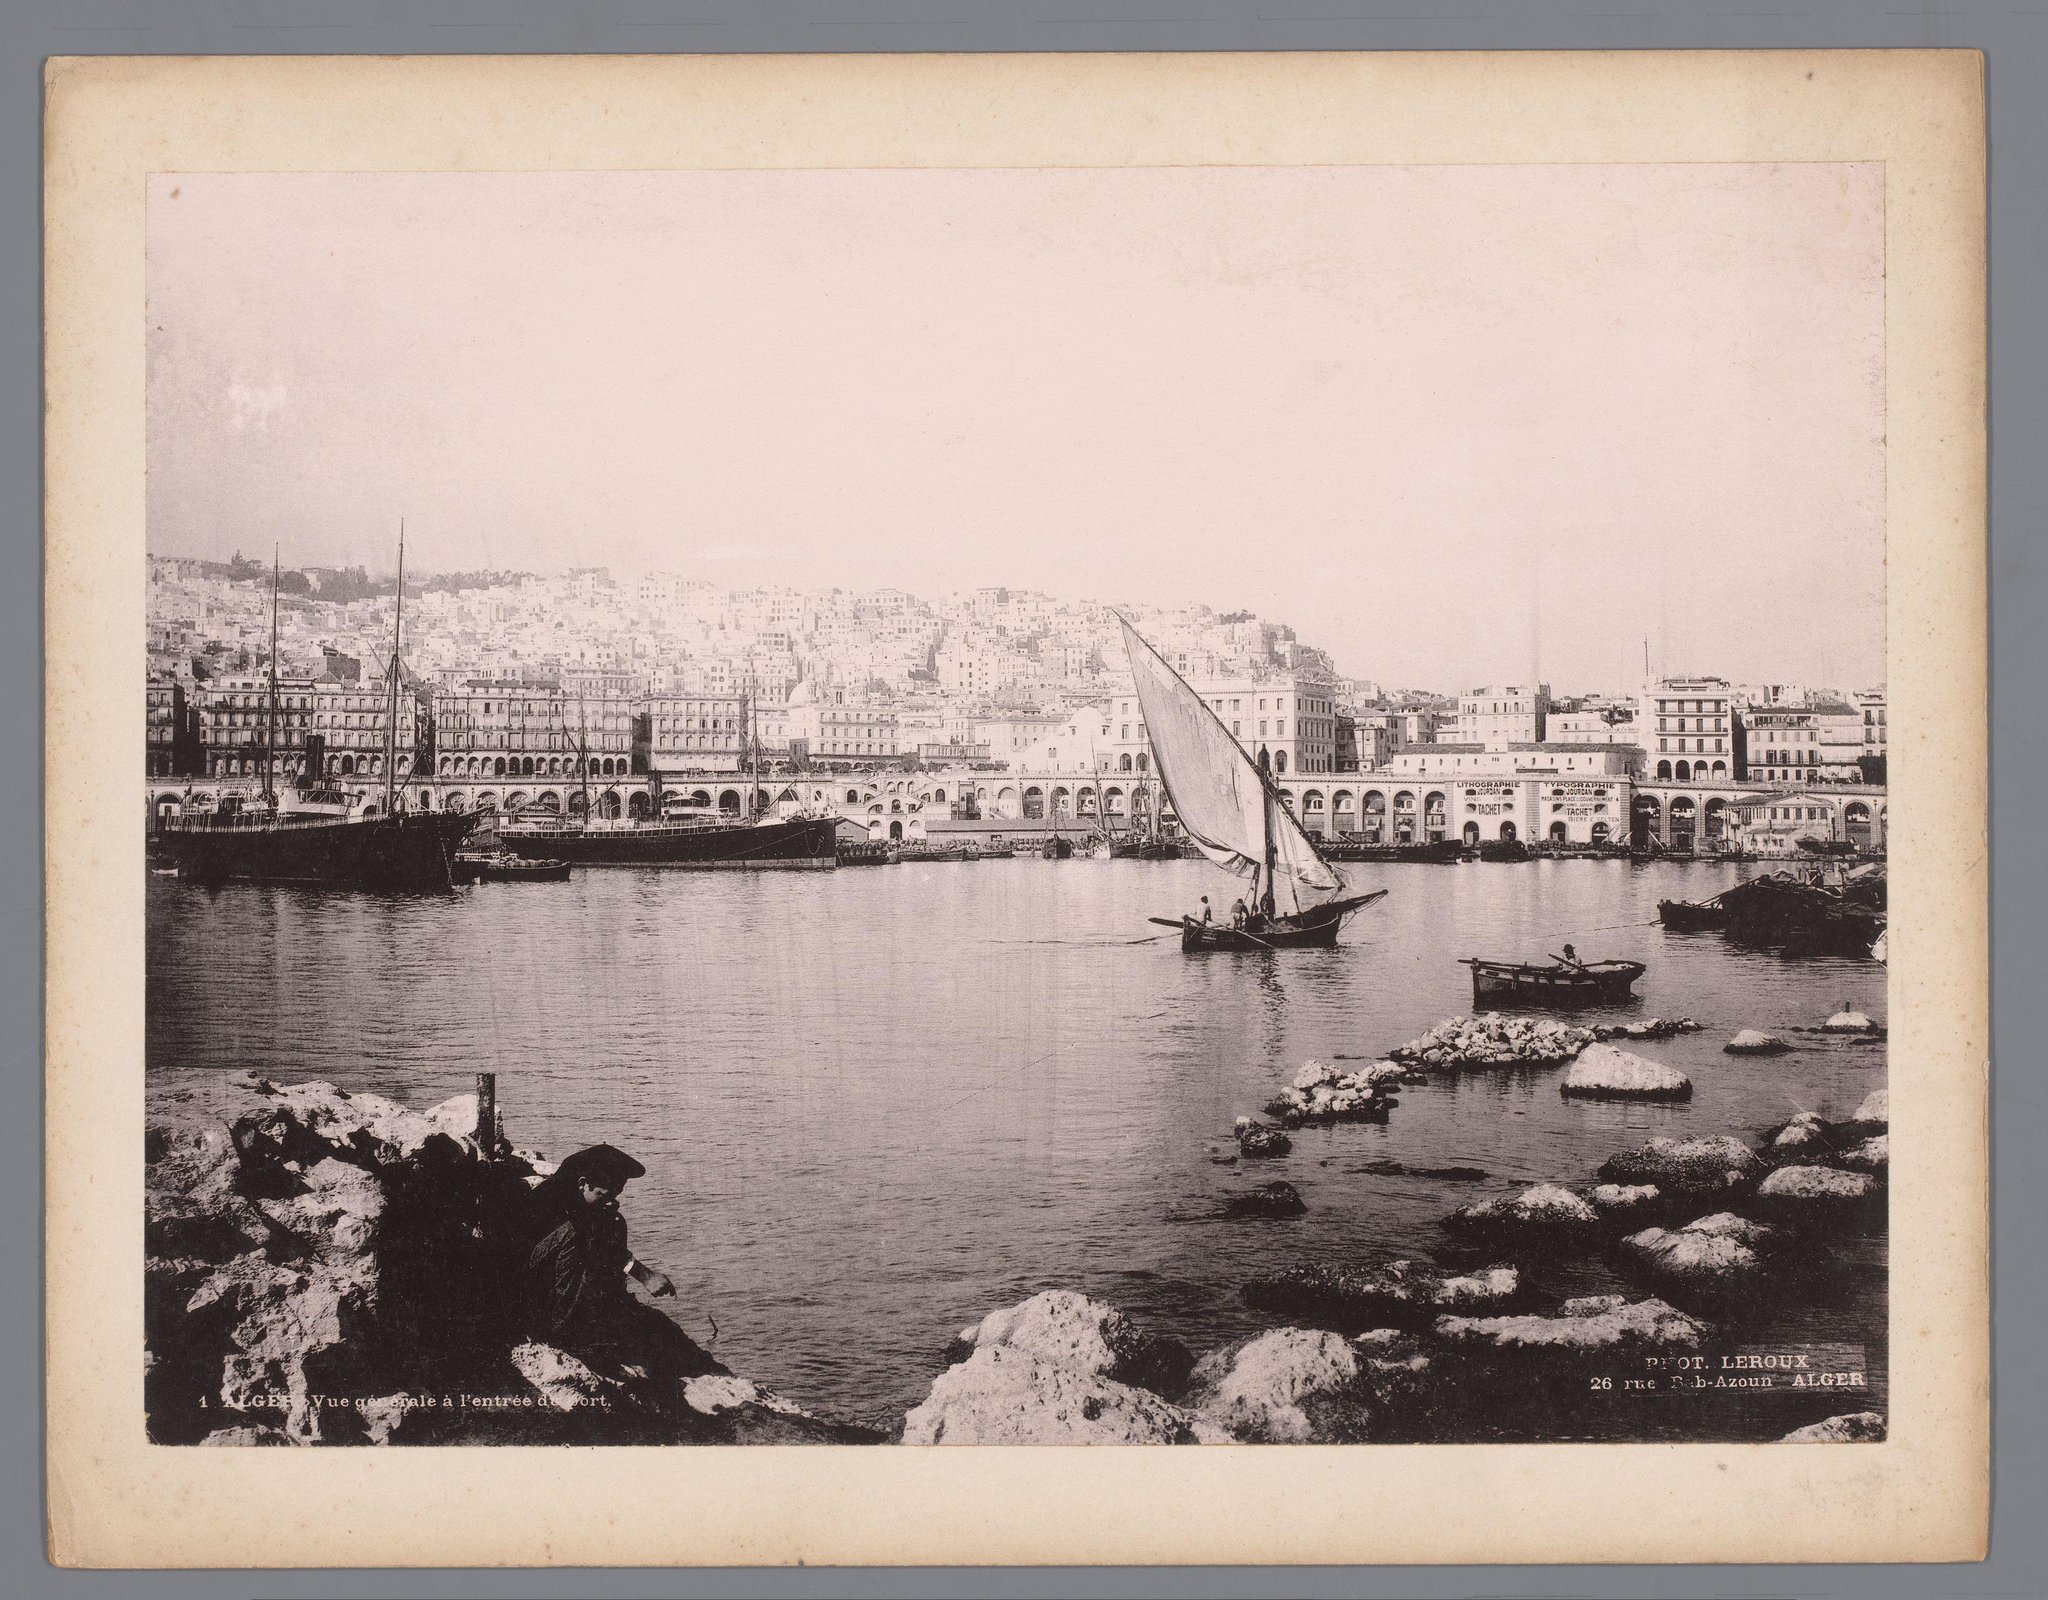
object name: photomechanical print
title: Gezicht op de haven van Algiers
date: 1875-1900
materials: cardboard, paper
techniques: photograph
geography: algiers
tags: harbour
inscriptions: address: ‘26 rue Bab-Azoun ALGER’, number: ‘1’